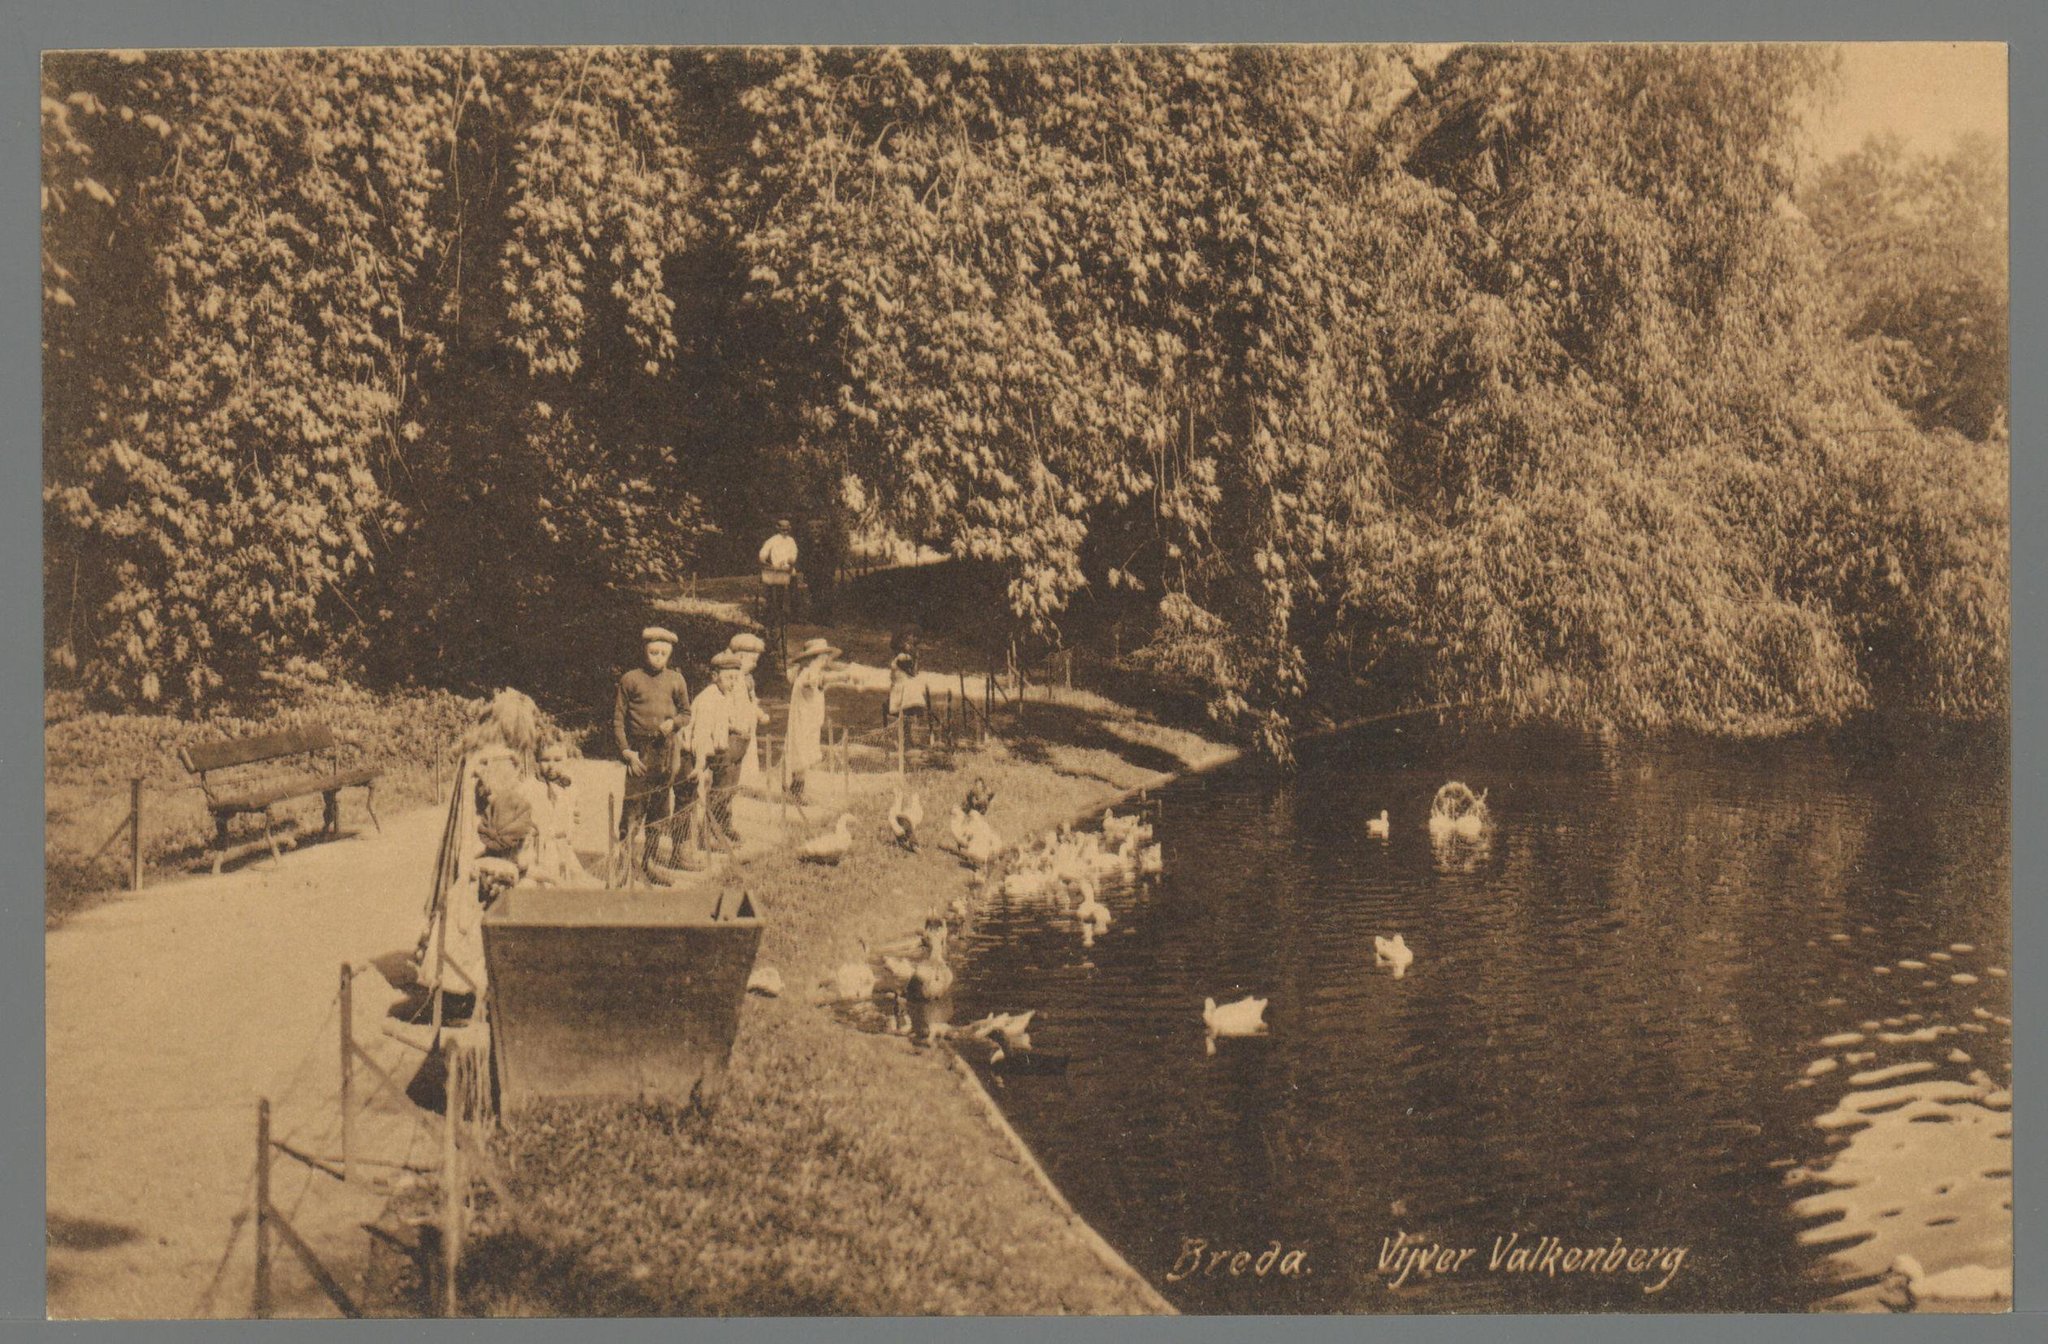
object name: photomechanical print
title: Breda. Vijver Valkenberg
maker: Anonymous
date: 1910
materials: cardboard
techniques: photograph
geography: breda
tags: park, pond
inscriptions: date